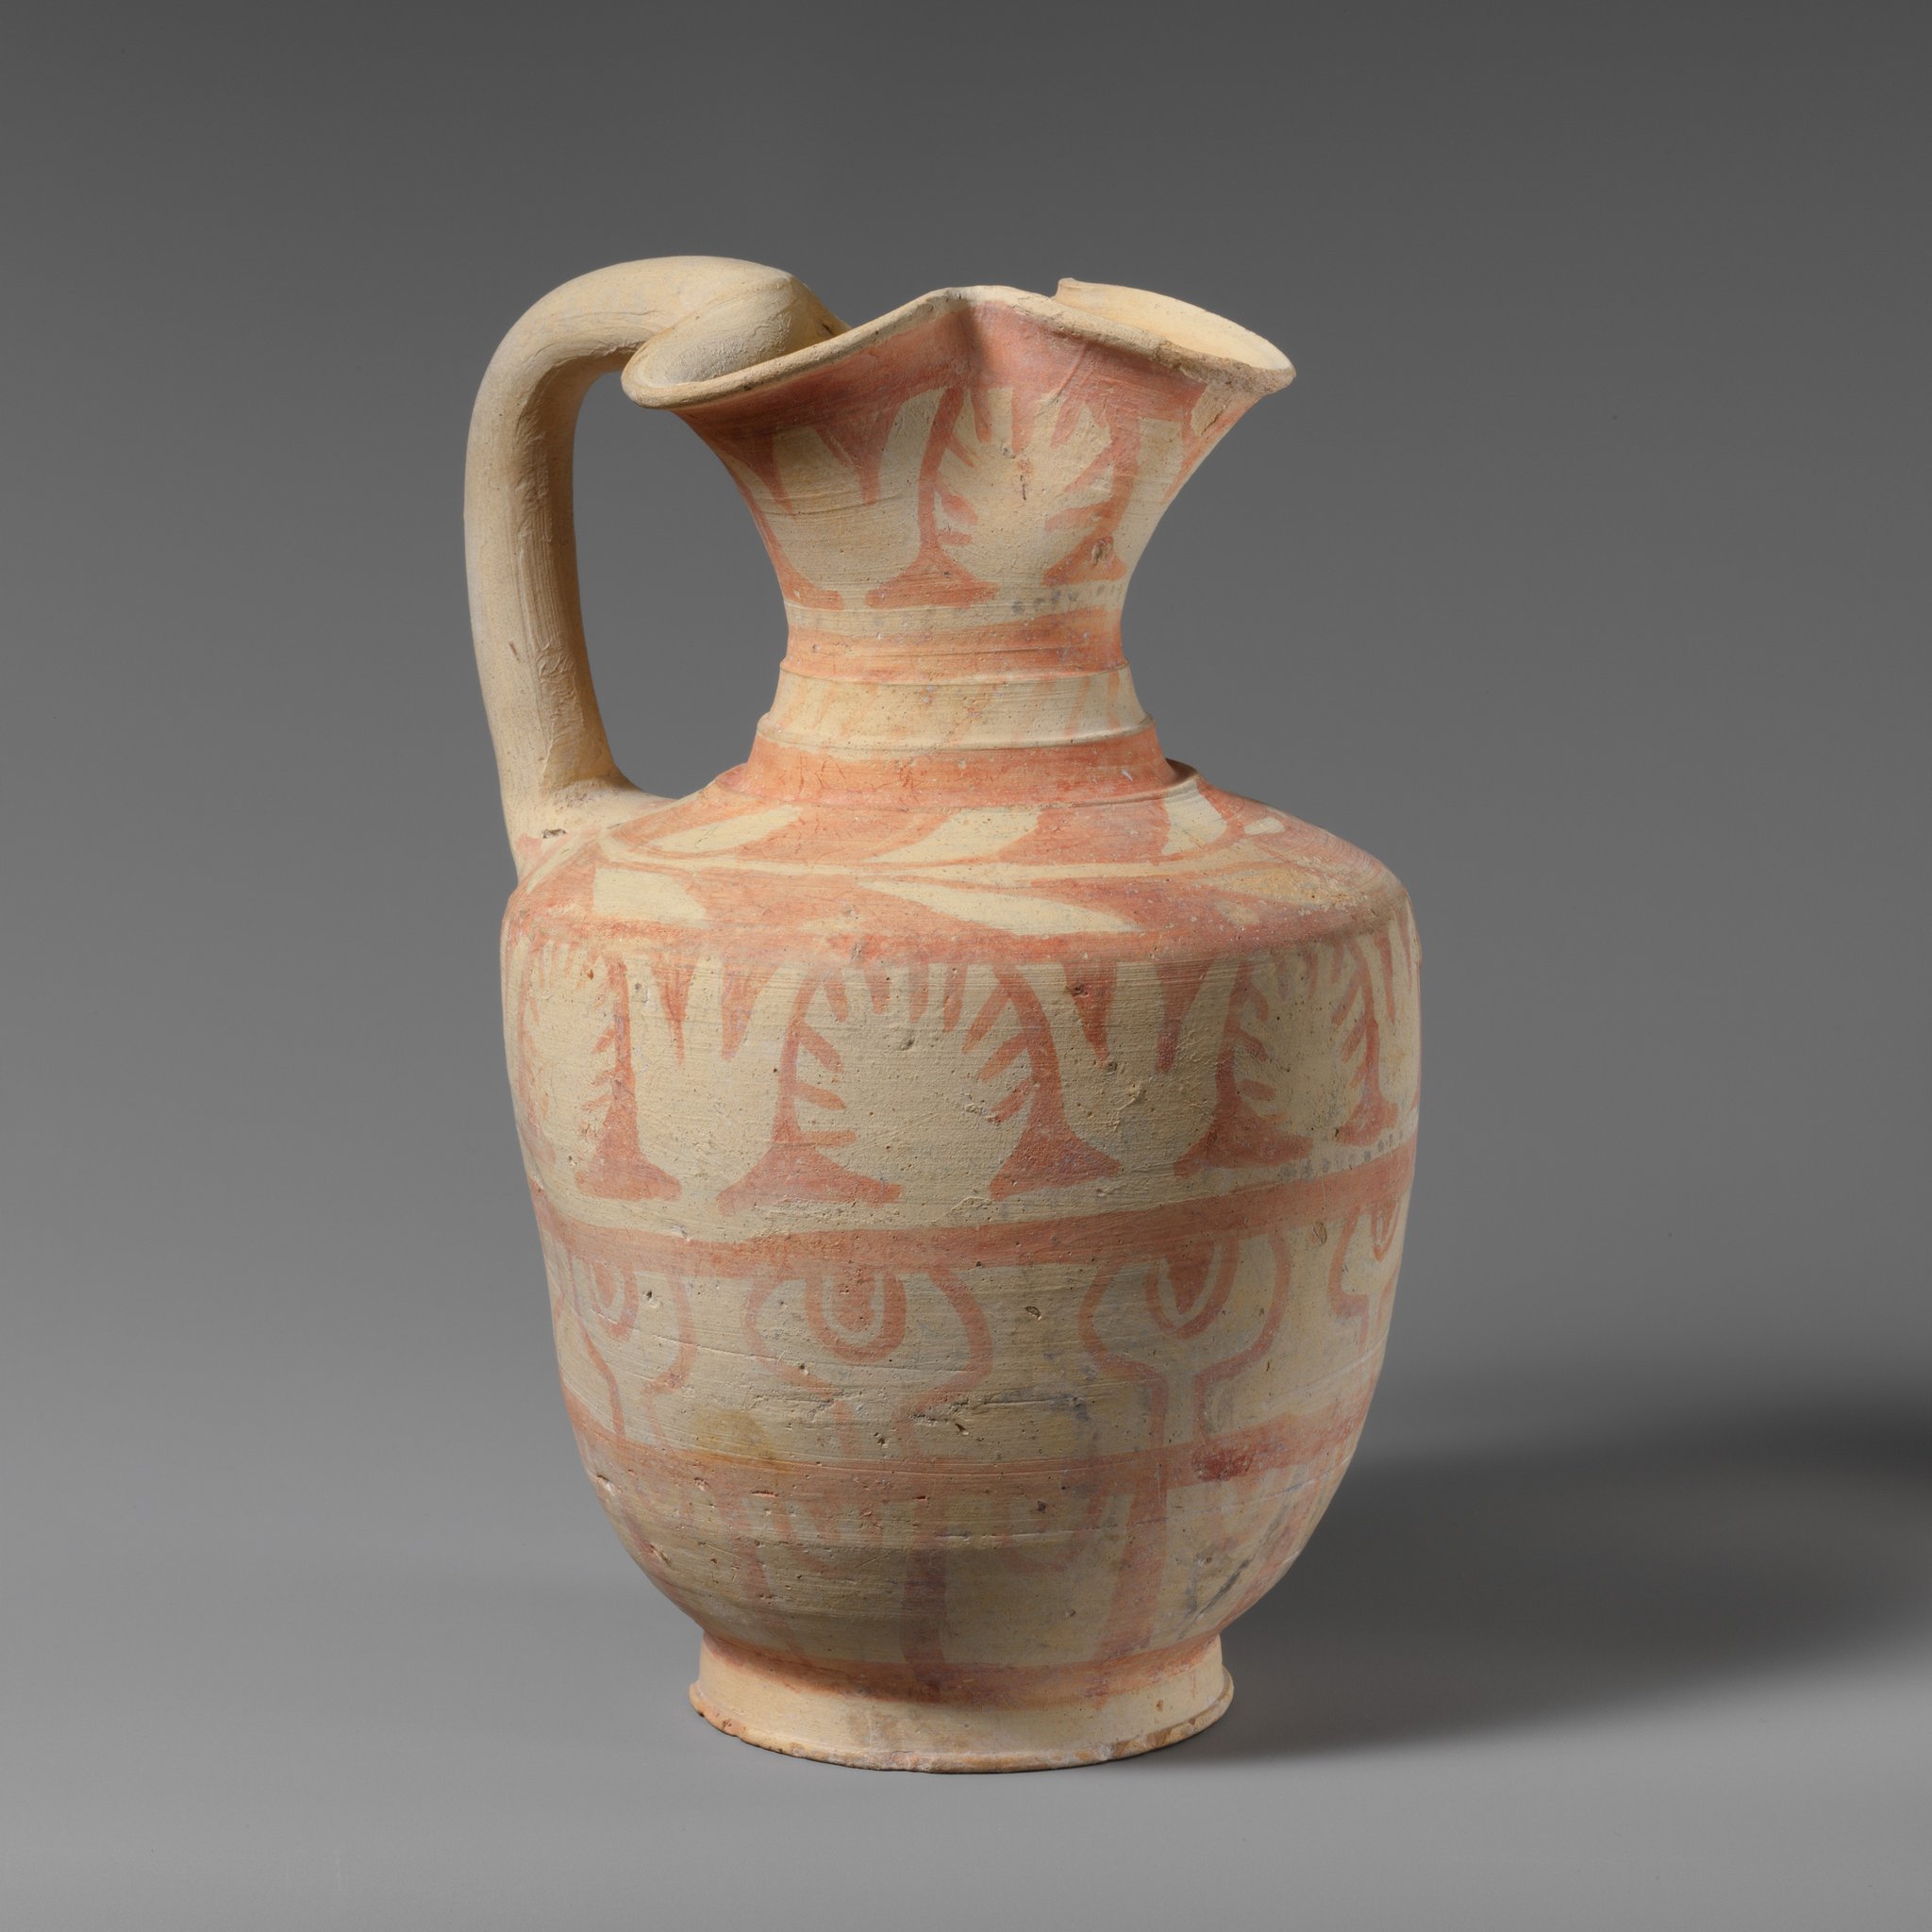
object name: jug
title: Terracotta jug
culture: cypriot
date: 310-30 BCE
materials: terracotta